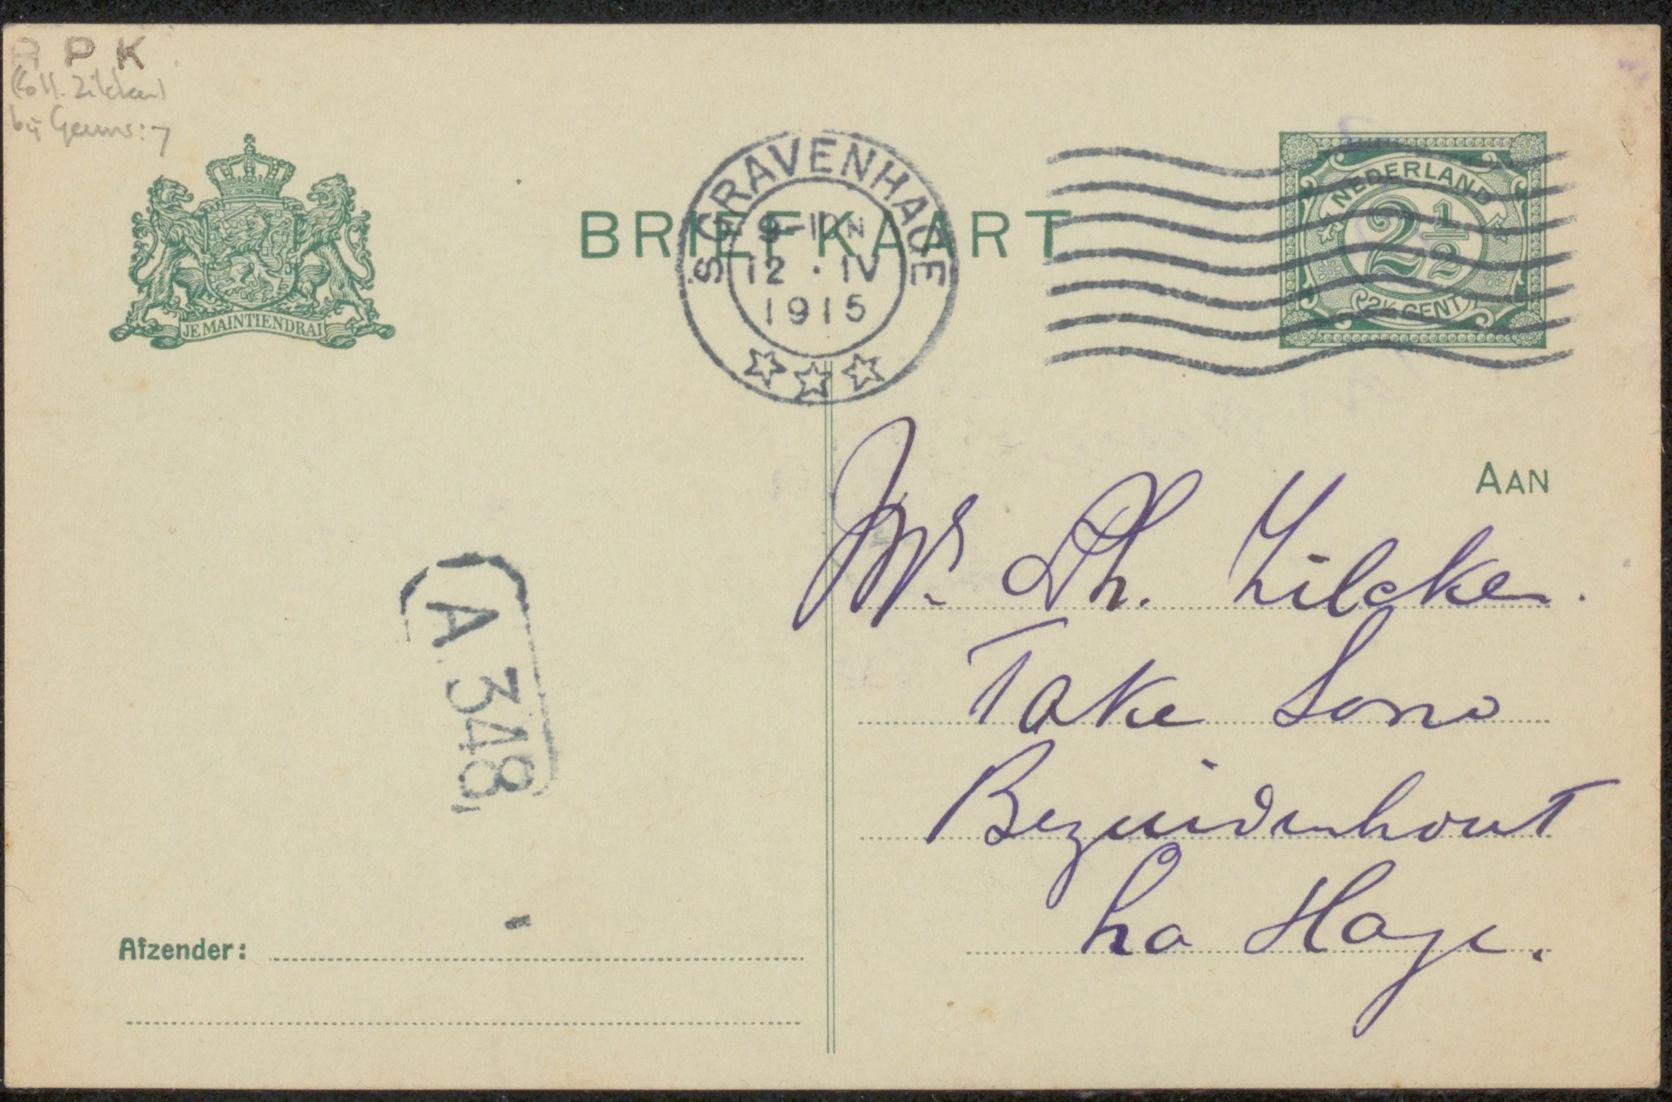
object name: postcard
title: Briefkaart aan Philip Zilcken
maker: carla van geuns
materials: cardboard, ink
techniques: pen, writing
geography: the hague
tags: paris, painter, draughtsman, etienne dinet, the hague, philip zilcken, painting (including book-illumination, miniature-painting), printed matter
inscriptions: collector's mark: ‘RPK’